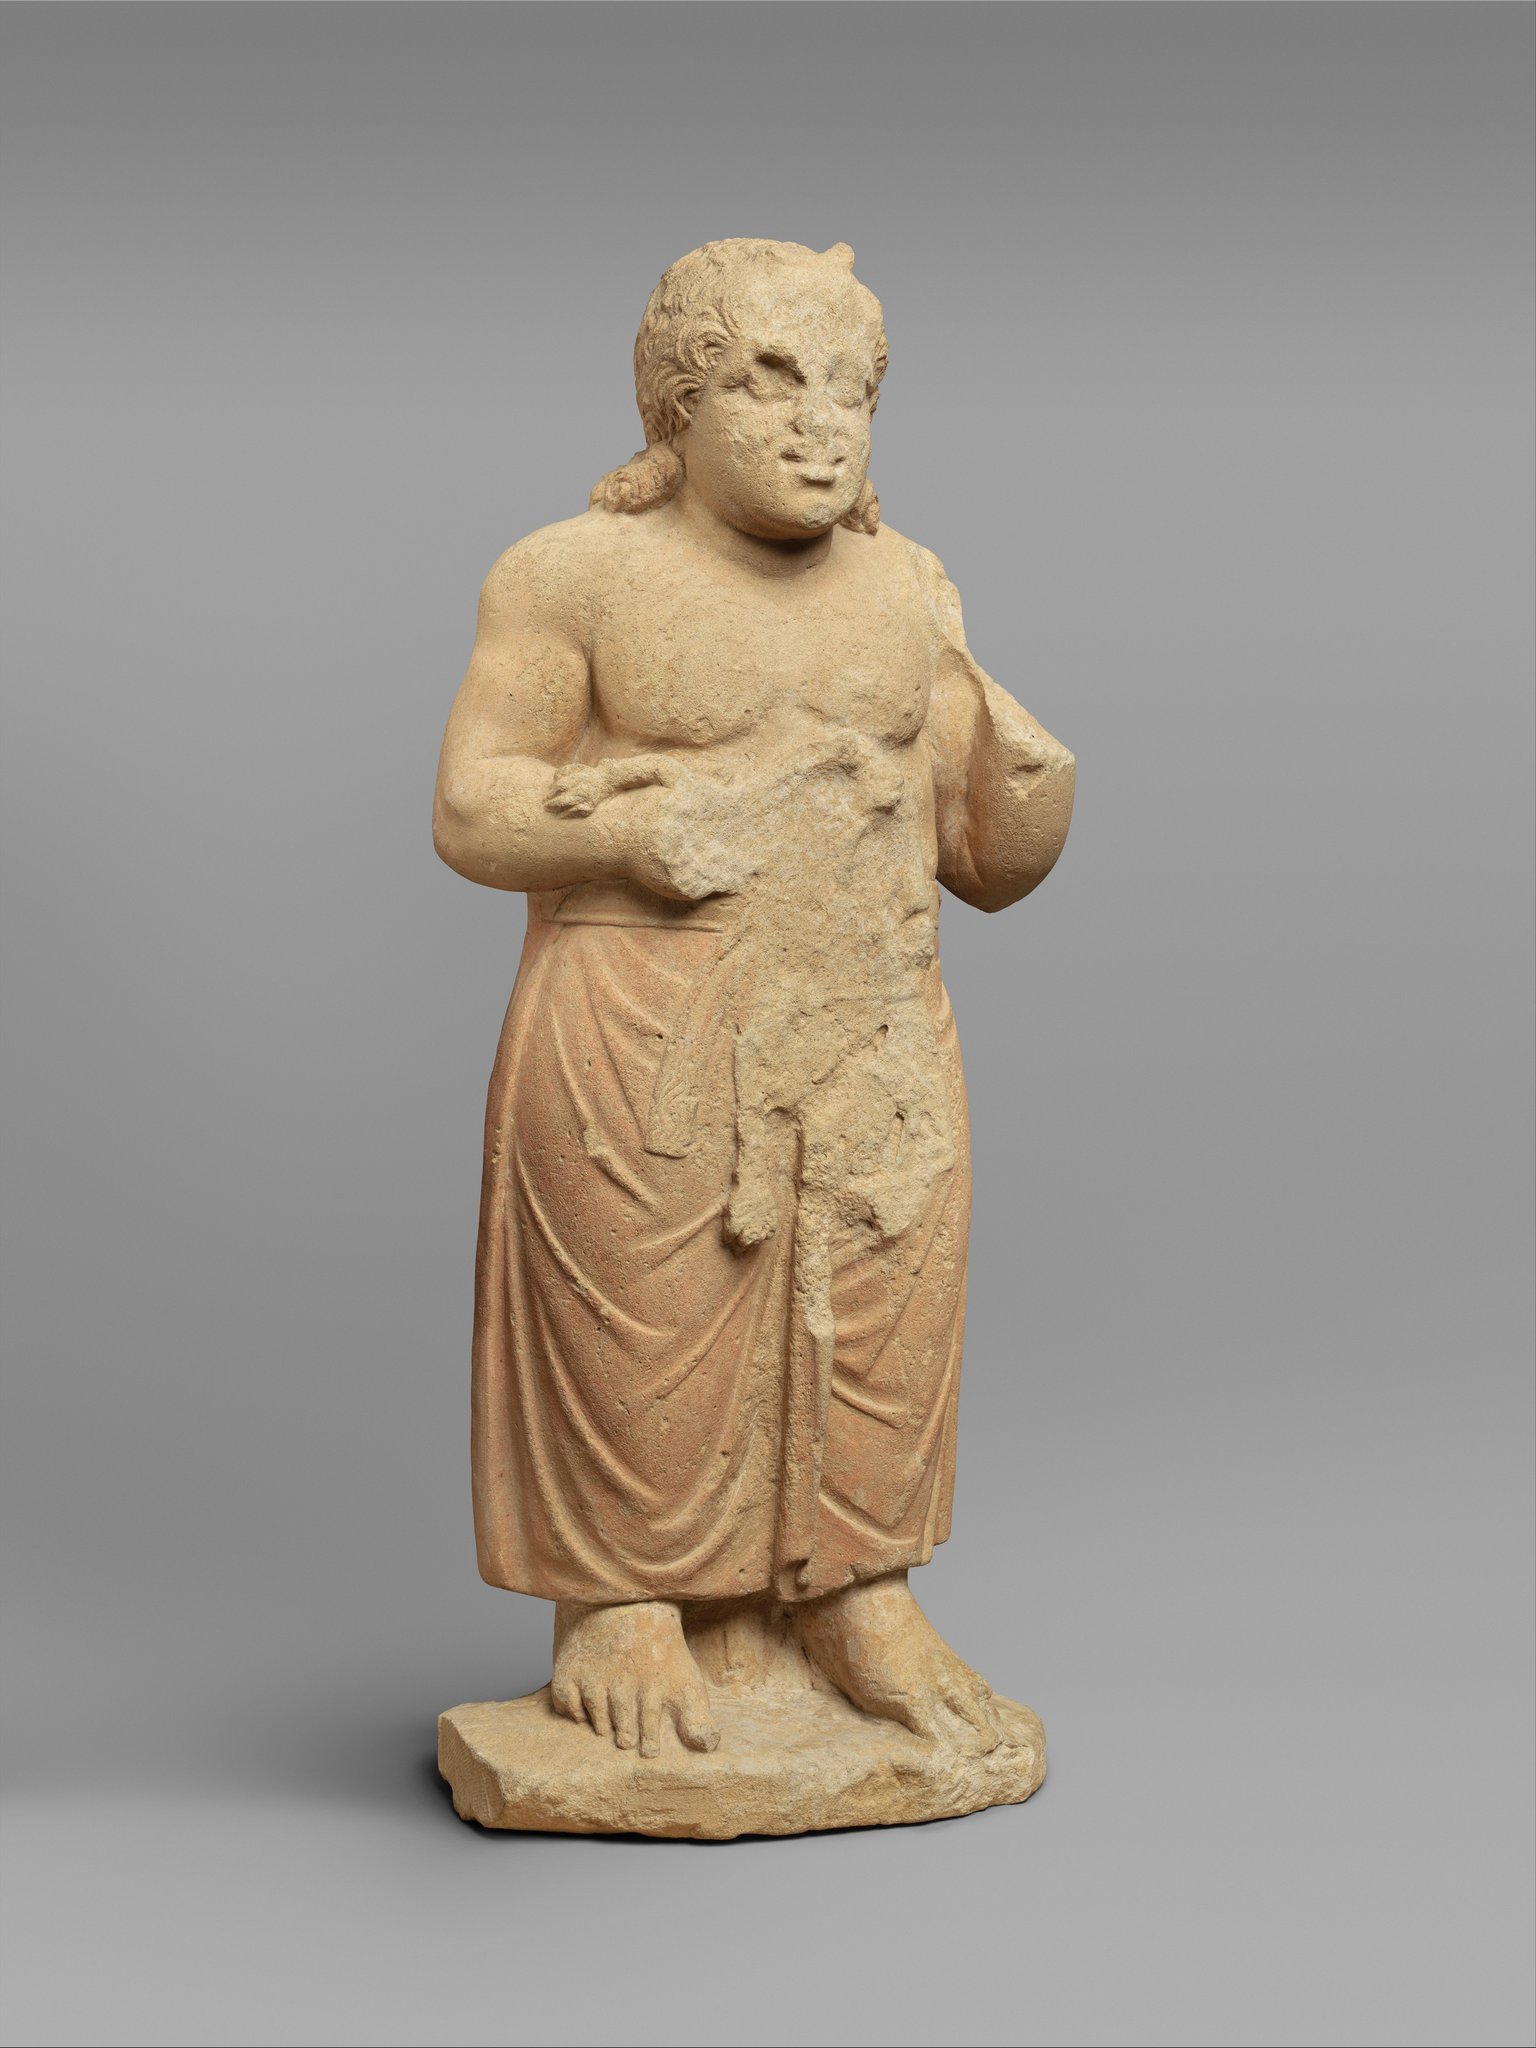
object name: statue of a man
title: Limestone statue of a god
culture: cypriot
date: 300-201 BCE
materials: limestone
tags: men,gods